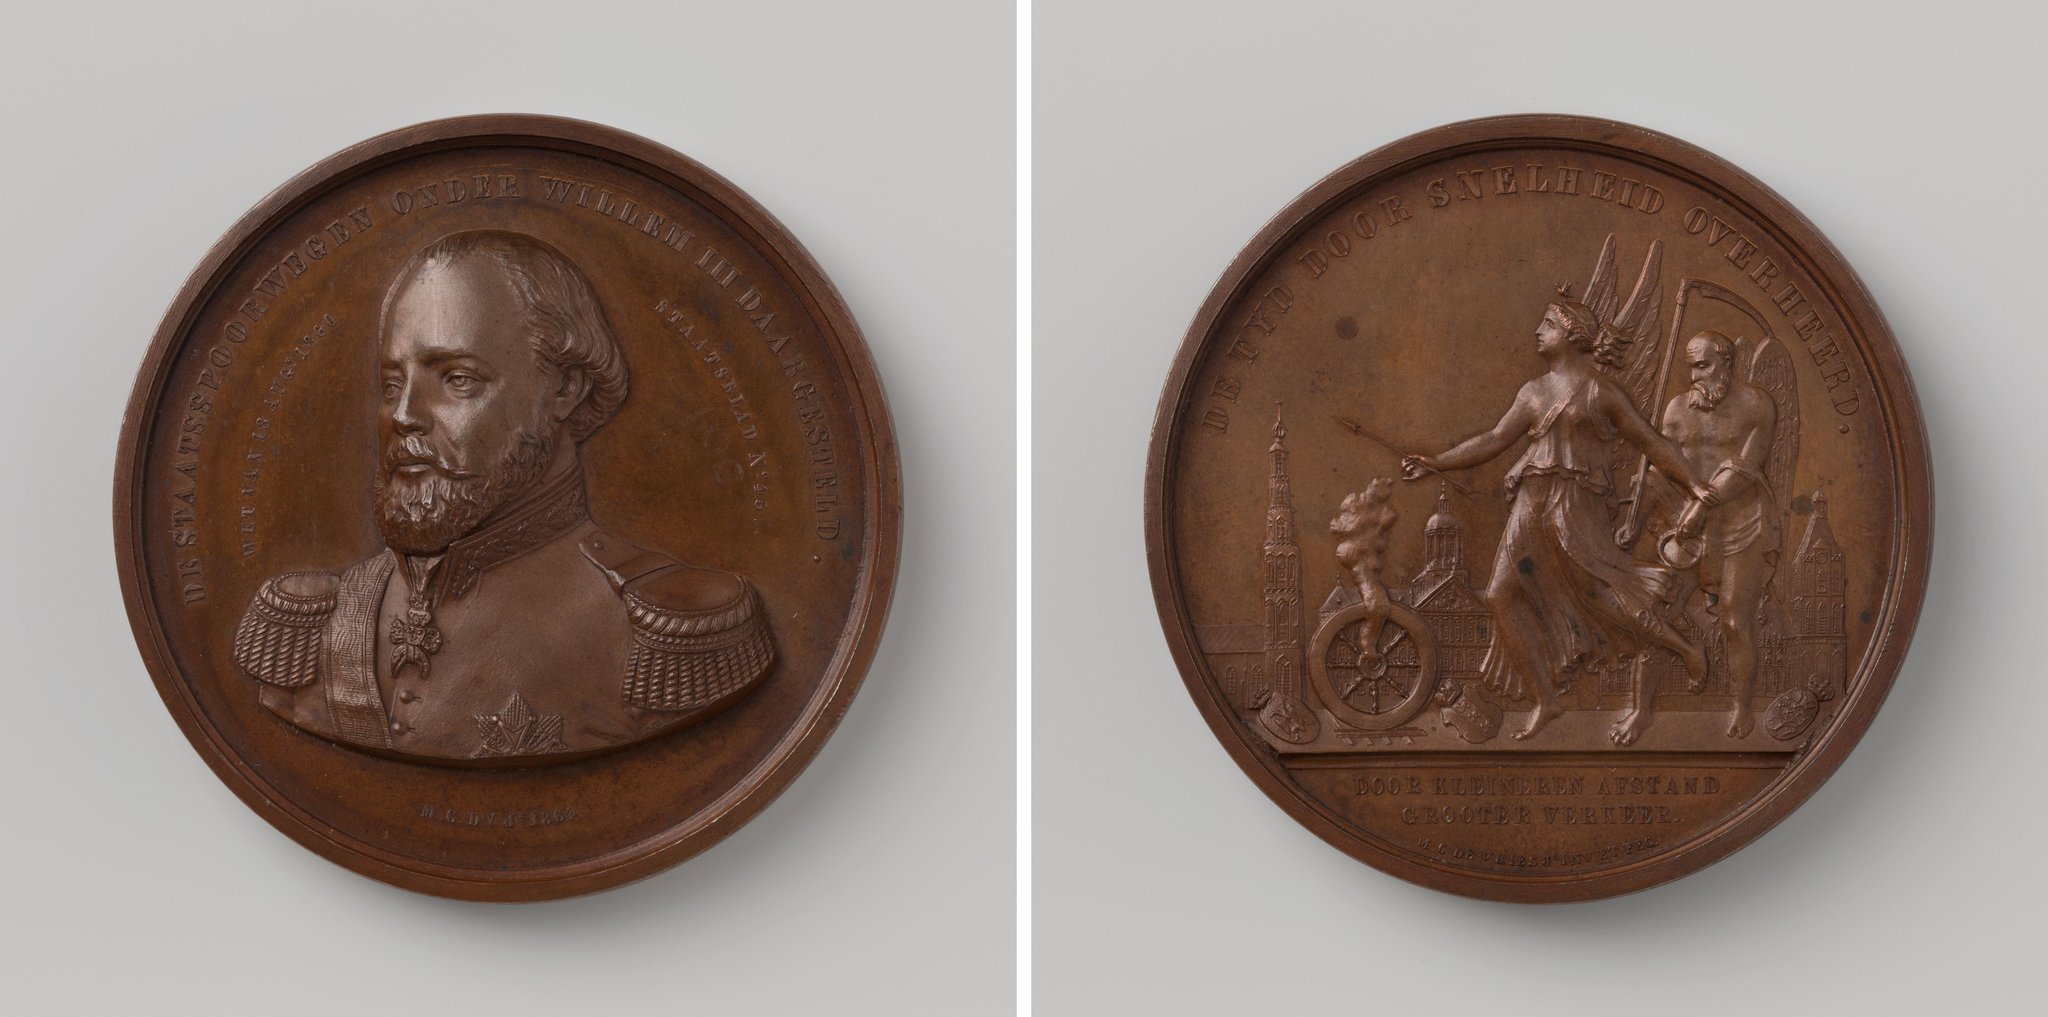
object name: history medal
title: Wet op de aanleg der Staatsspoorwegen, ter ere van Willem III, koning der Nederlanden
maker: moses cohen de vries junior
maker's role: diamantslijper, graveur, medailleur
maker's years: 1807-1883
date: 1864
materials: bronze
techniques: striking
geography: amsterdam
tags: brussels, willem iii (koning der nederlanden)